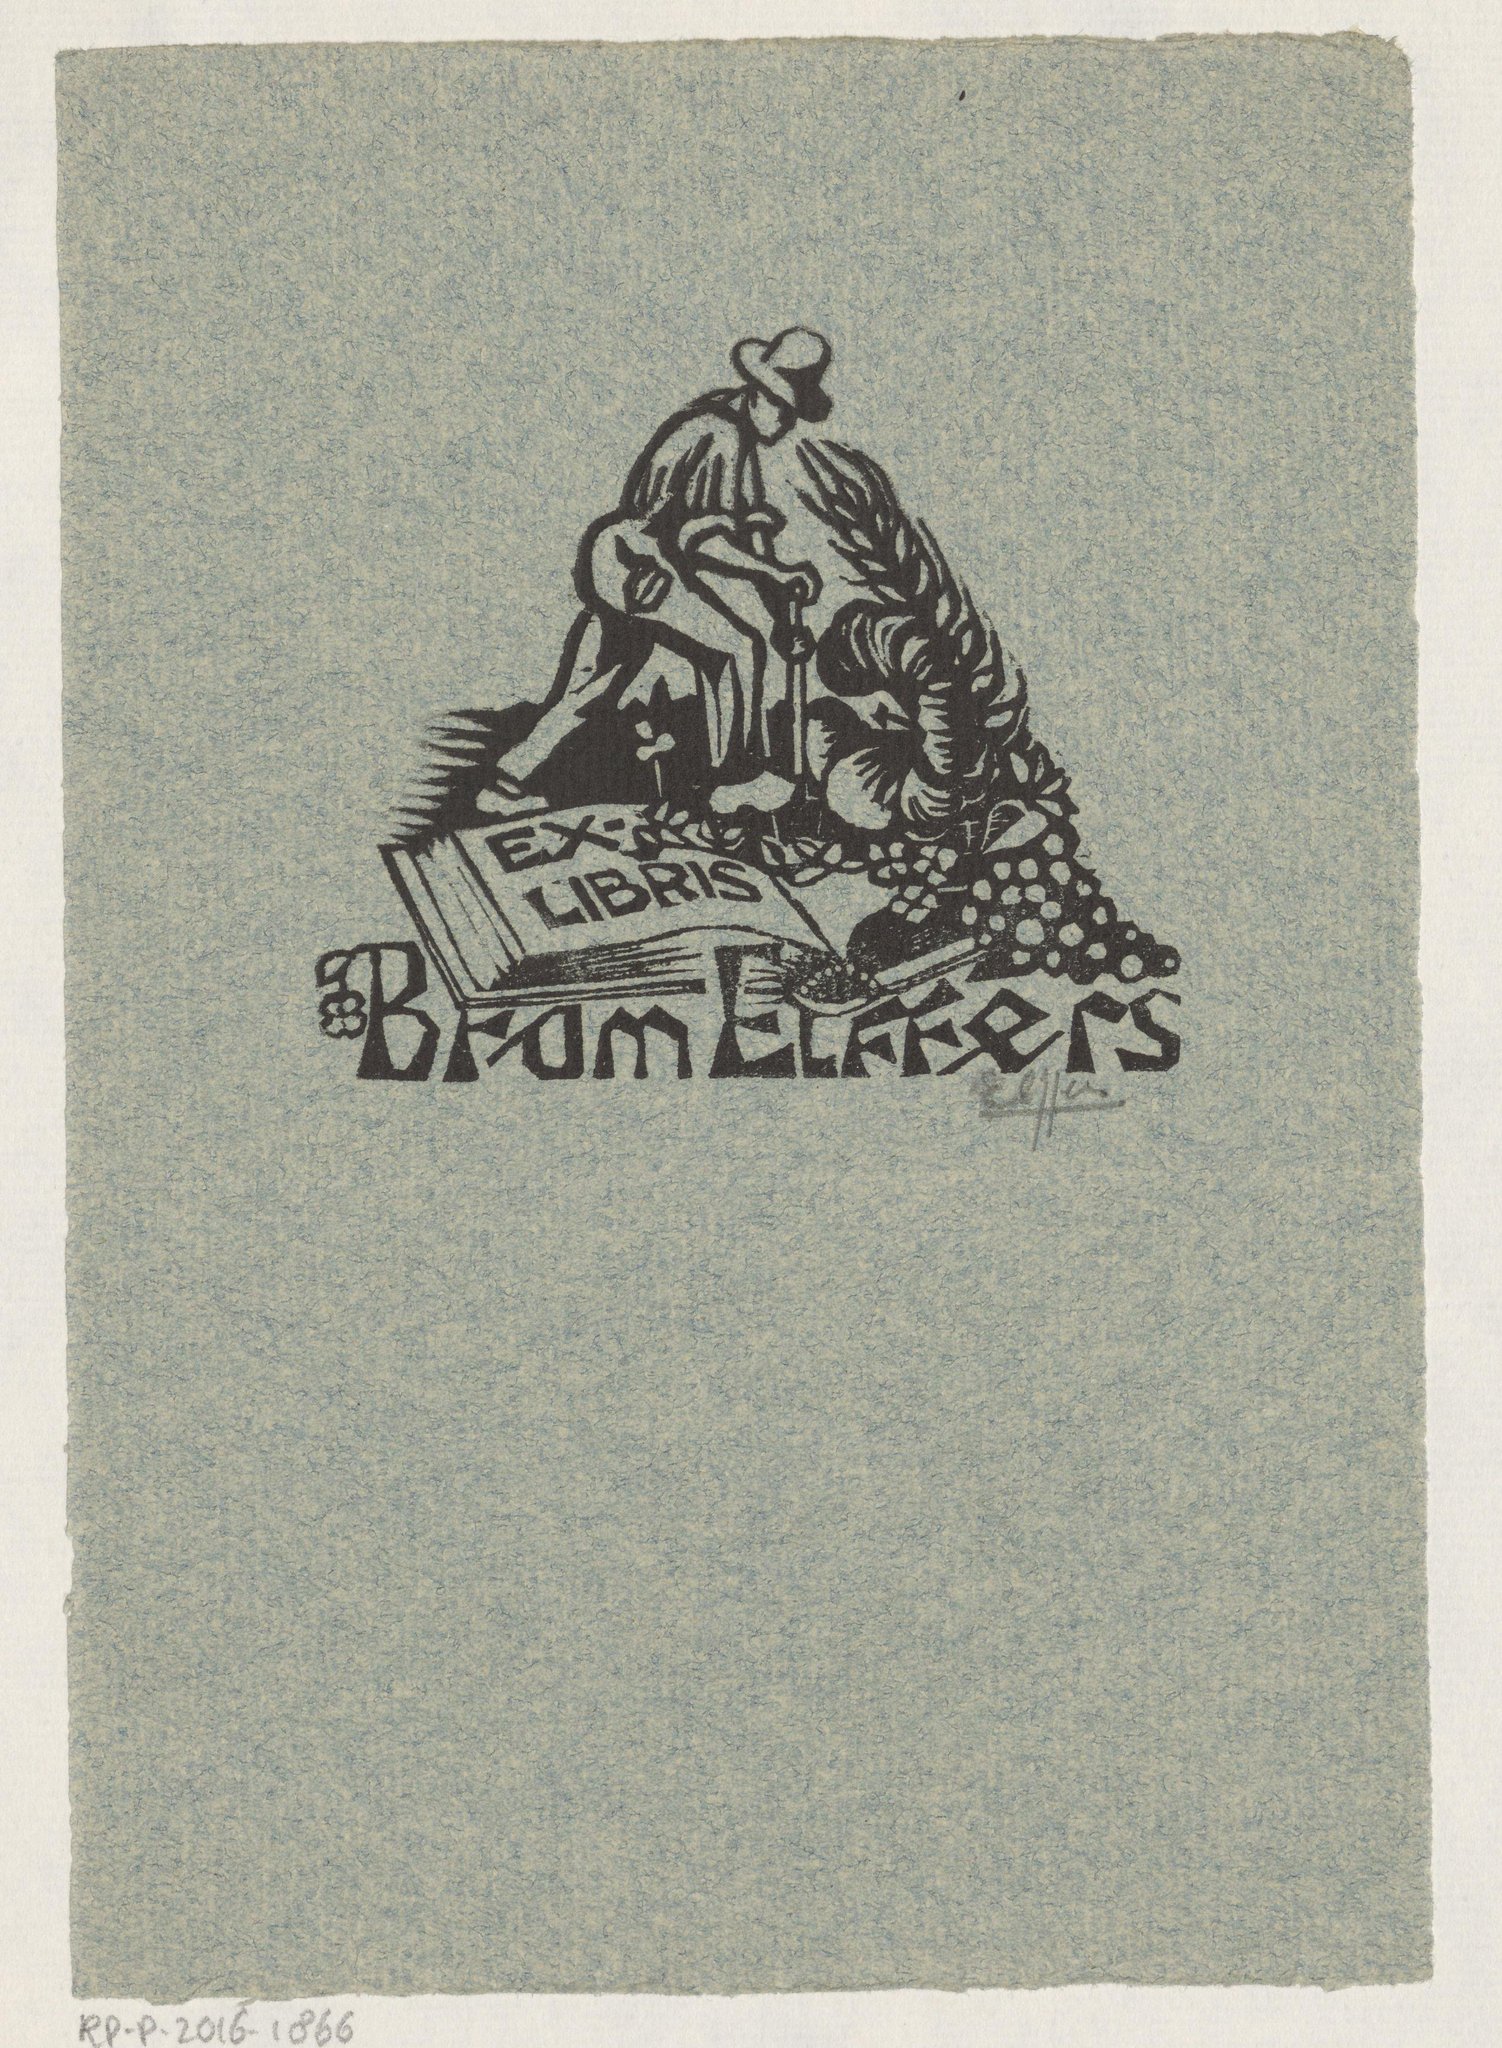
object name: bookplate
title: Ex libris van Bram Elffers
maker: jan elffers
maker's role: print maker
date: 1941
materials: paper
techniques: woodcut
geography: netherlands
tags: horticulture, vegetable culture, market gardening, digging (industrial process), gardening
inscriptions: signature: ‘Elffers’